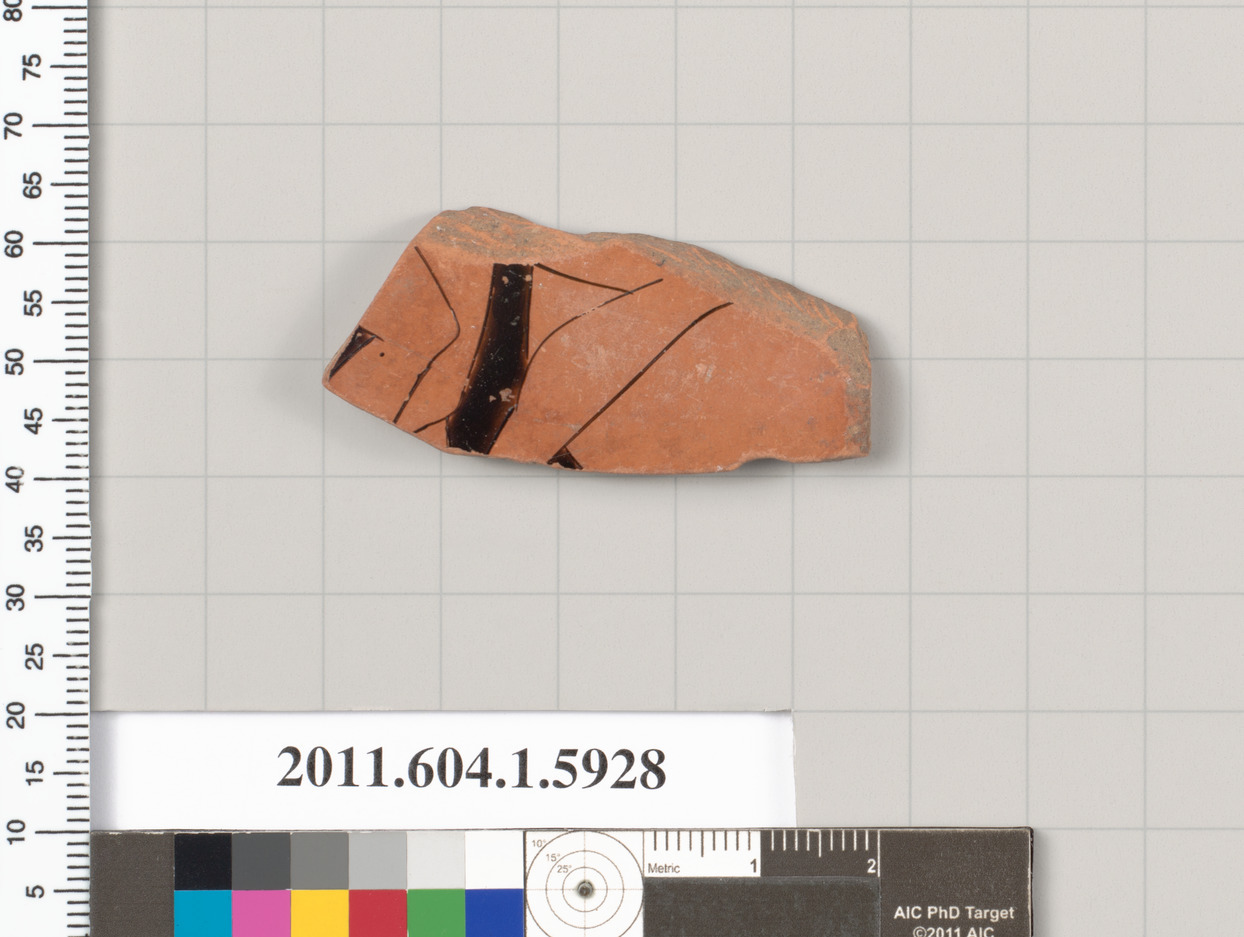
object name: kylix fragment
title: Terracotta fragment of a kylix (drinking cup)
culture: greek, attic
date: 520-510 BCE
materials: terracotta